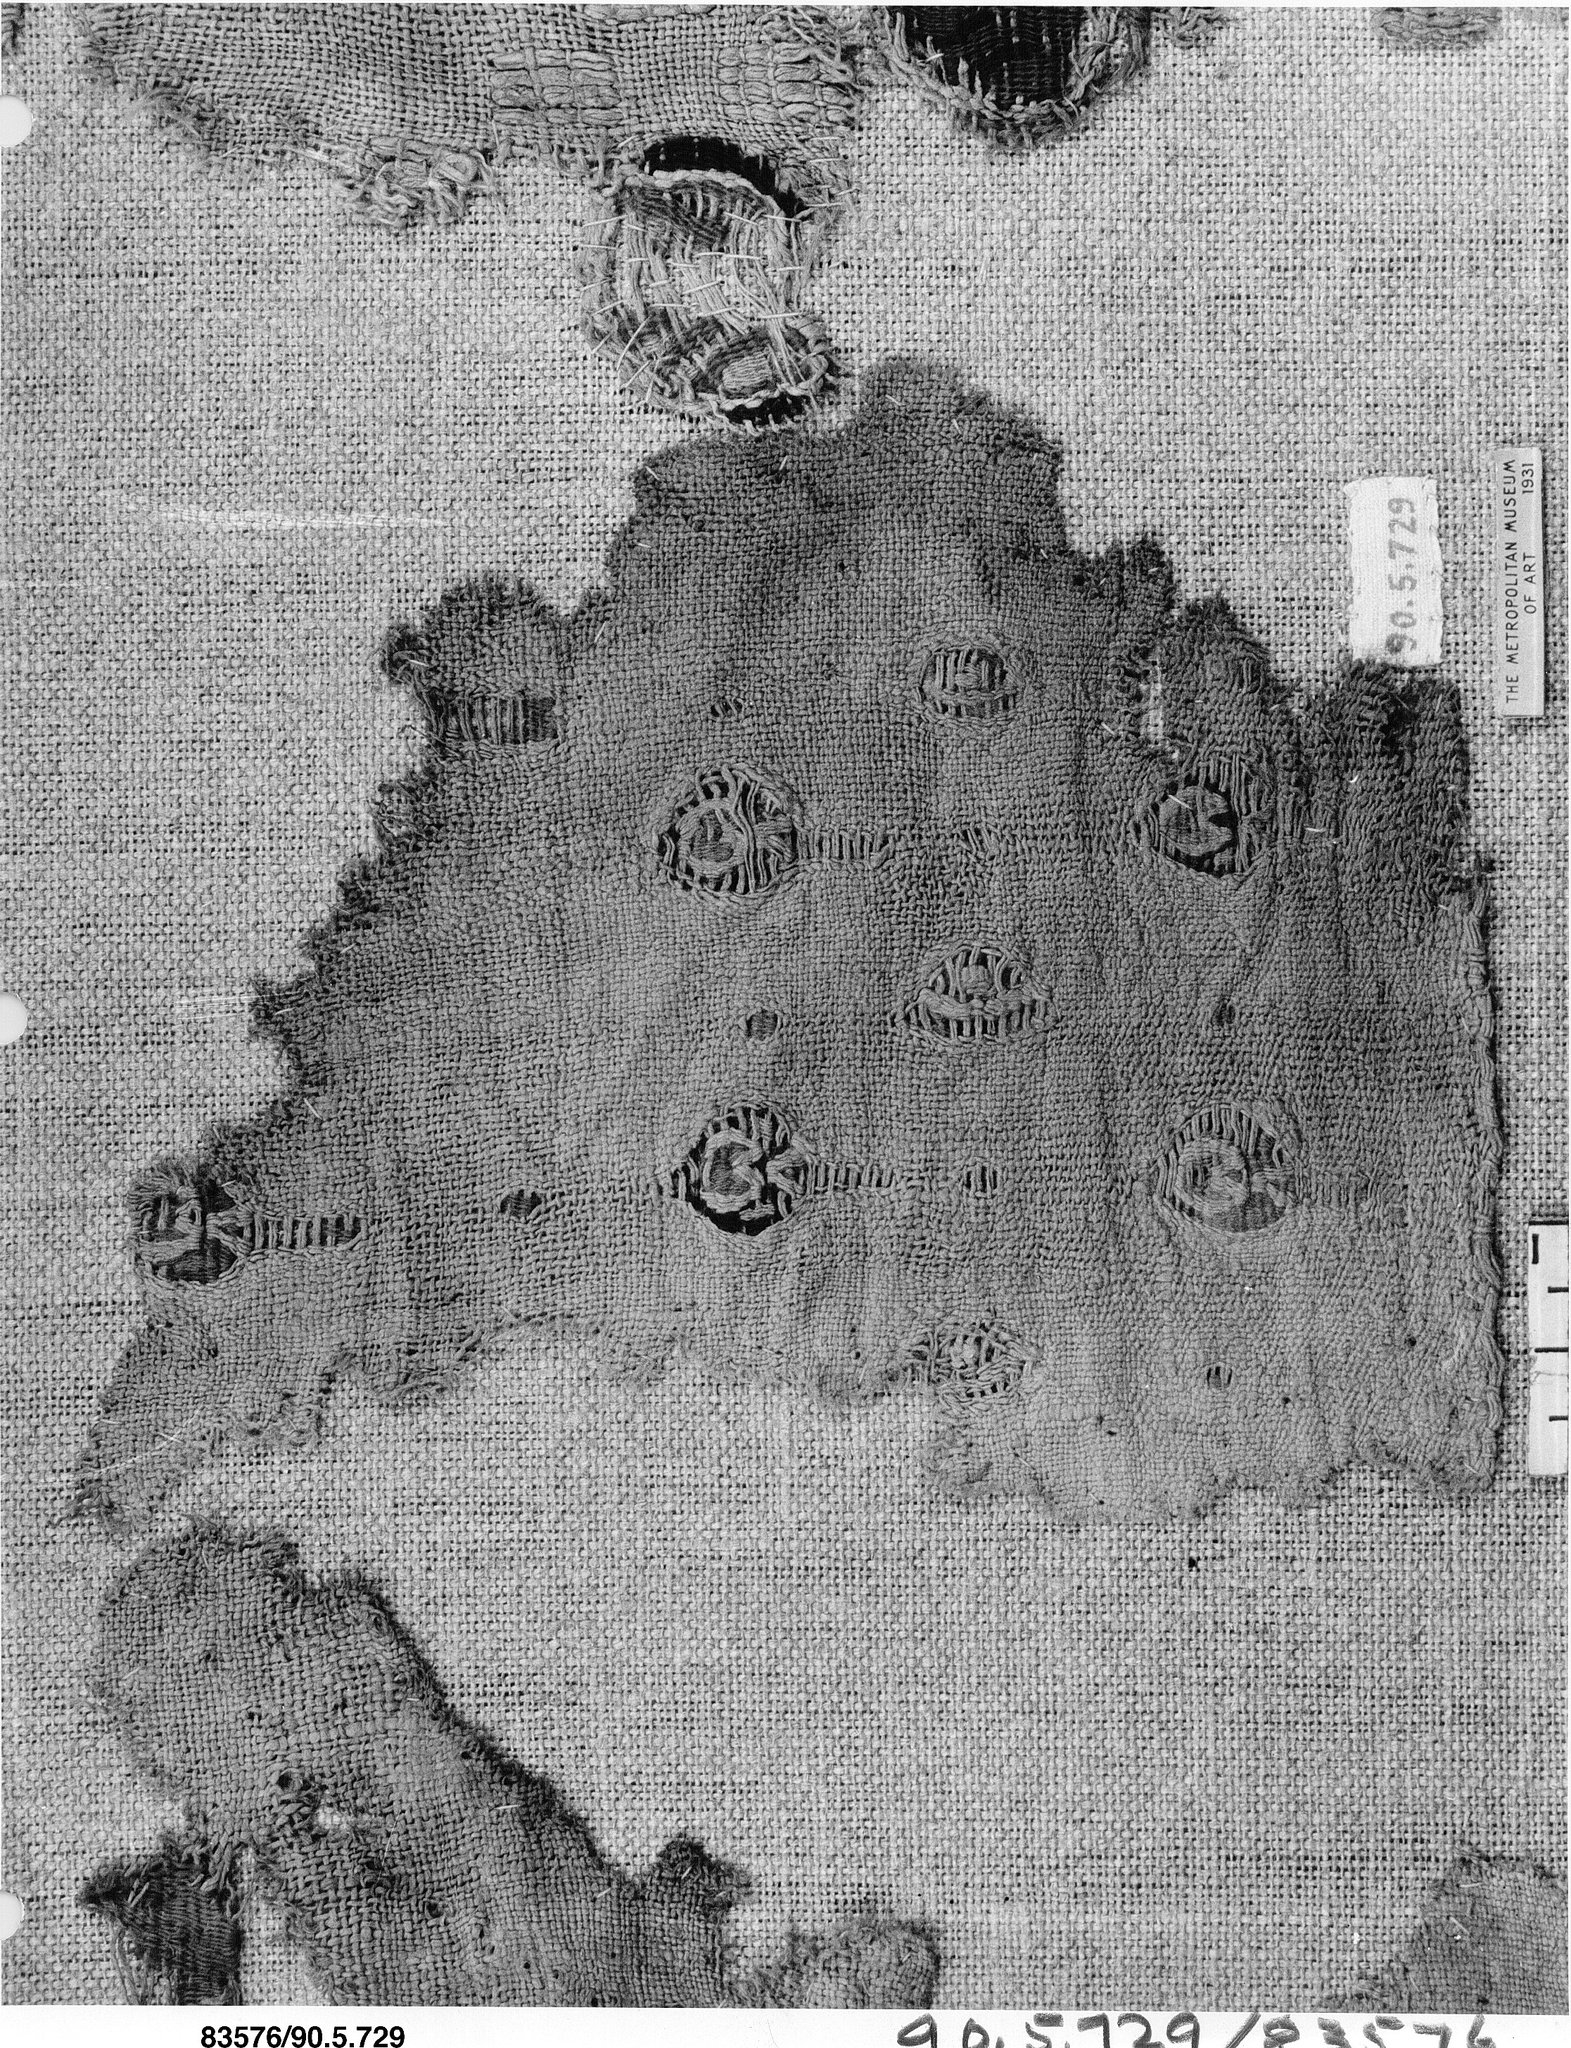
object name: textile fragment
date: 401-600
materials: linen, wool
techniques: weave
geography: egypt